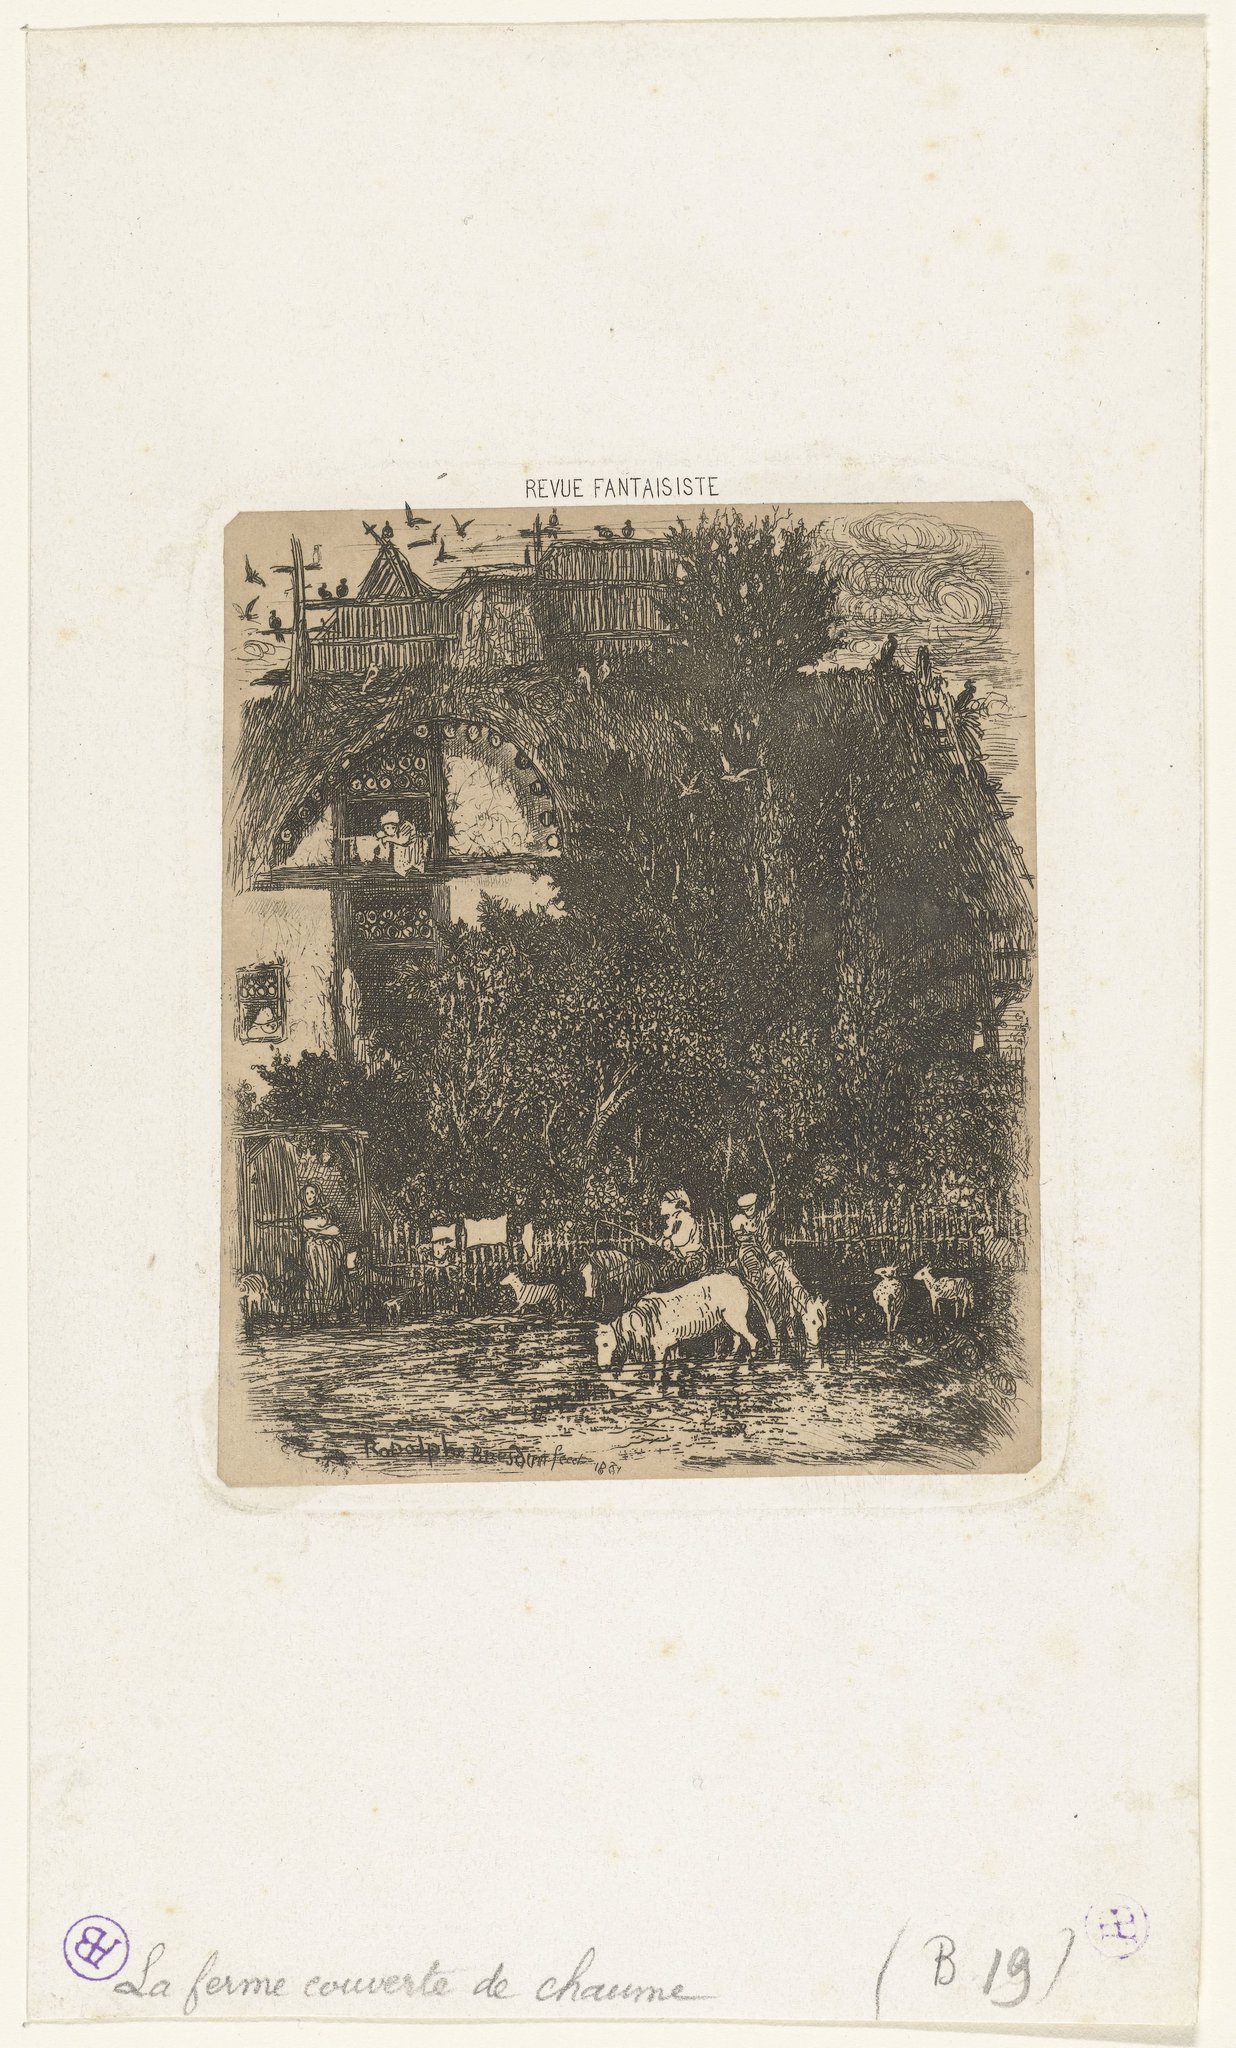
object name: print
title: Boerderij met duiventil op dak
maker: rodolphe bresdin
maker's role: draughtsman, print maker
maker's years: 1822-1885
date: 1861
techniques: printmaking, etching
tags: farm or solitary house in landscape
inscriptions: collector's mark: Lugt 2228, collector's mark: Lugt 76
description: Boerderij met een duiventil op het dak aan een zandweg met een plas water. Een vrouw hangt iets uit het raam onder een gebogen dakrand. Op de voorgrond drijven twee ruiters schapen door het water. Boven de voorstelling staat de tekst Revue Fantaisiste.